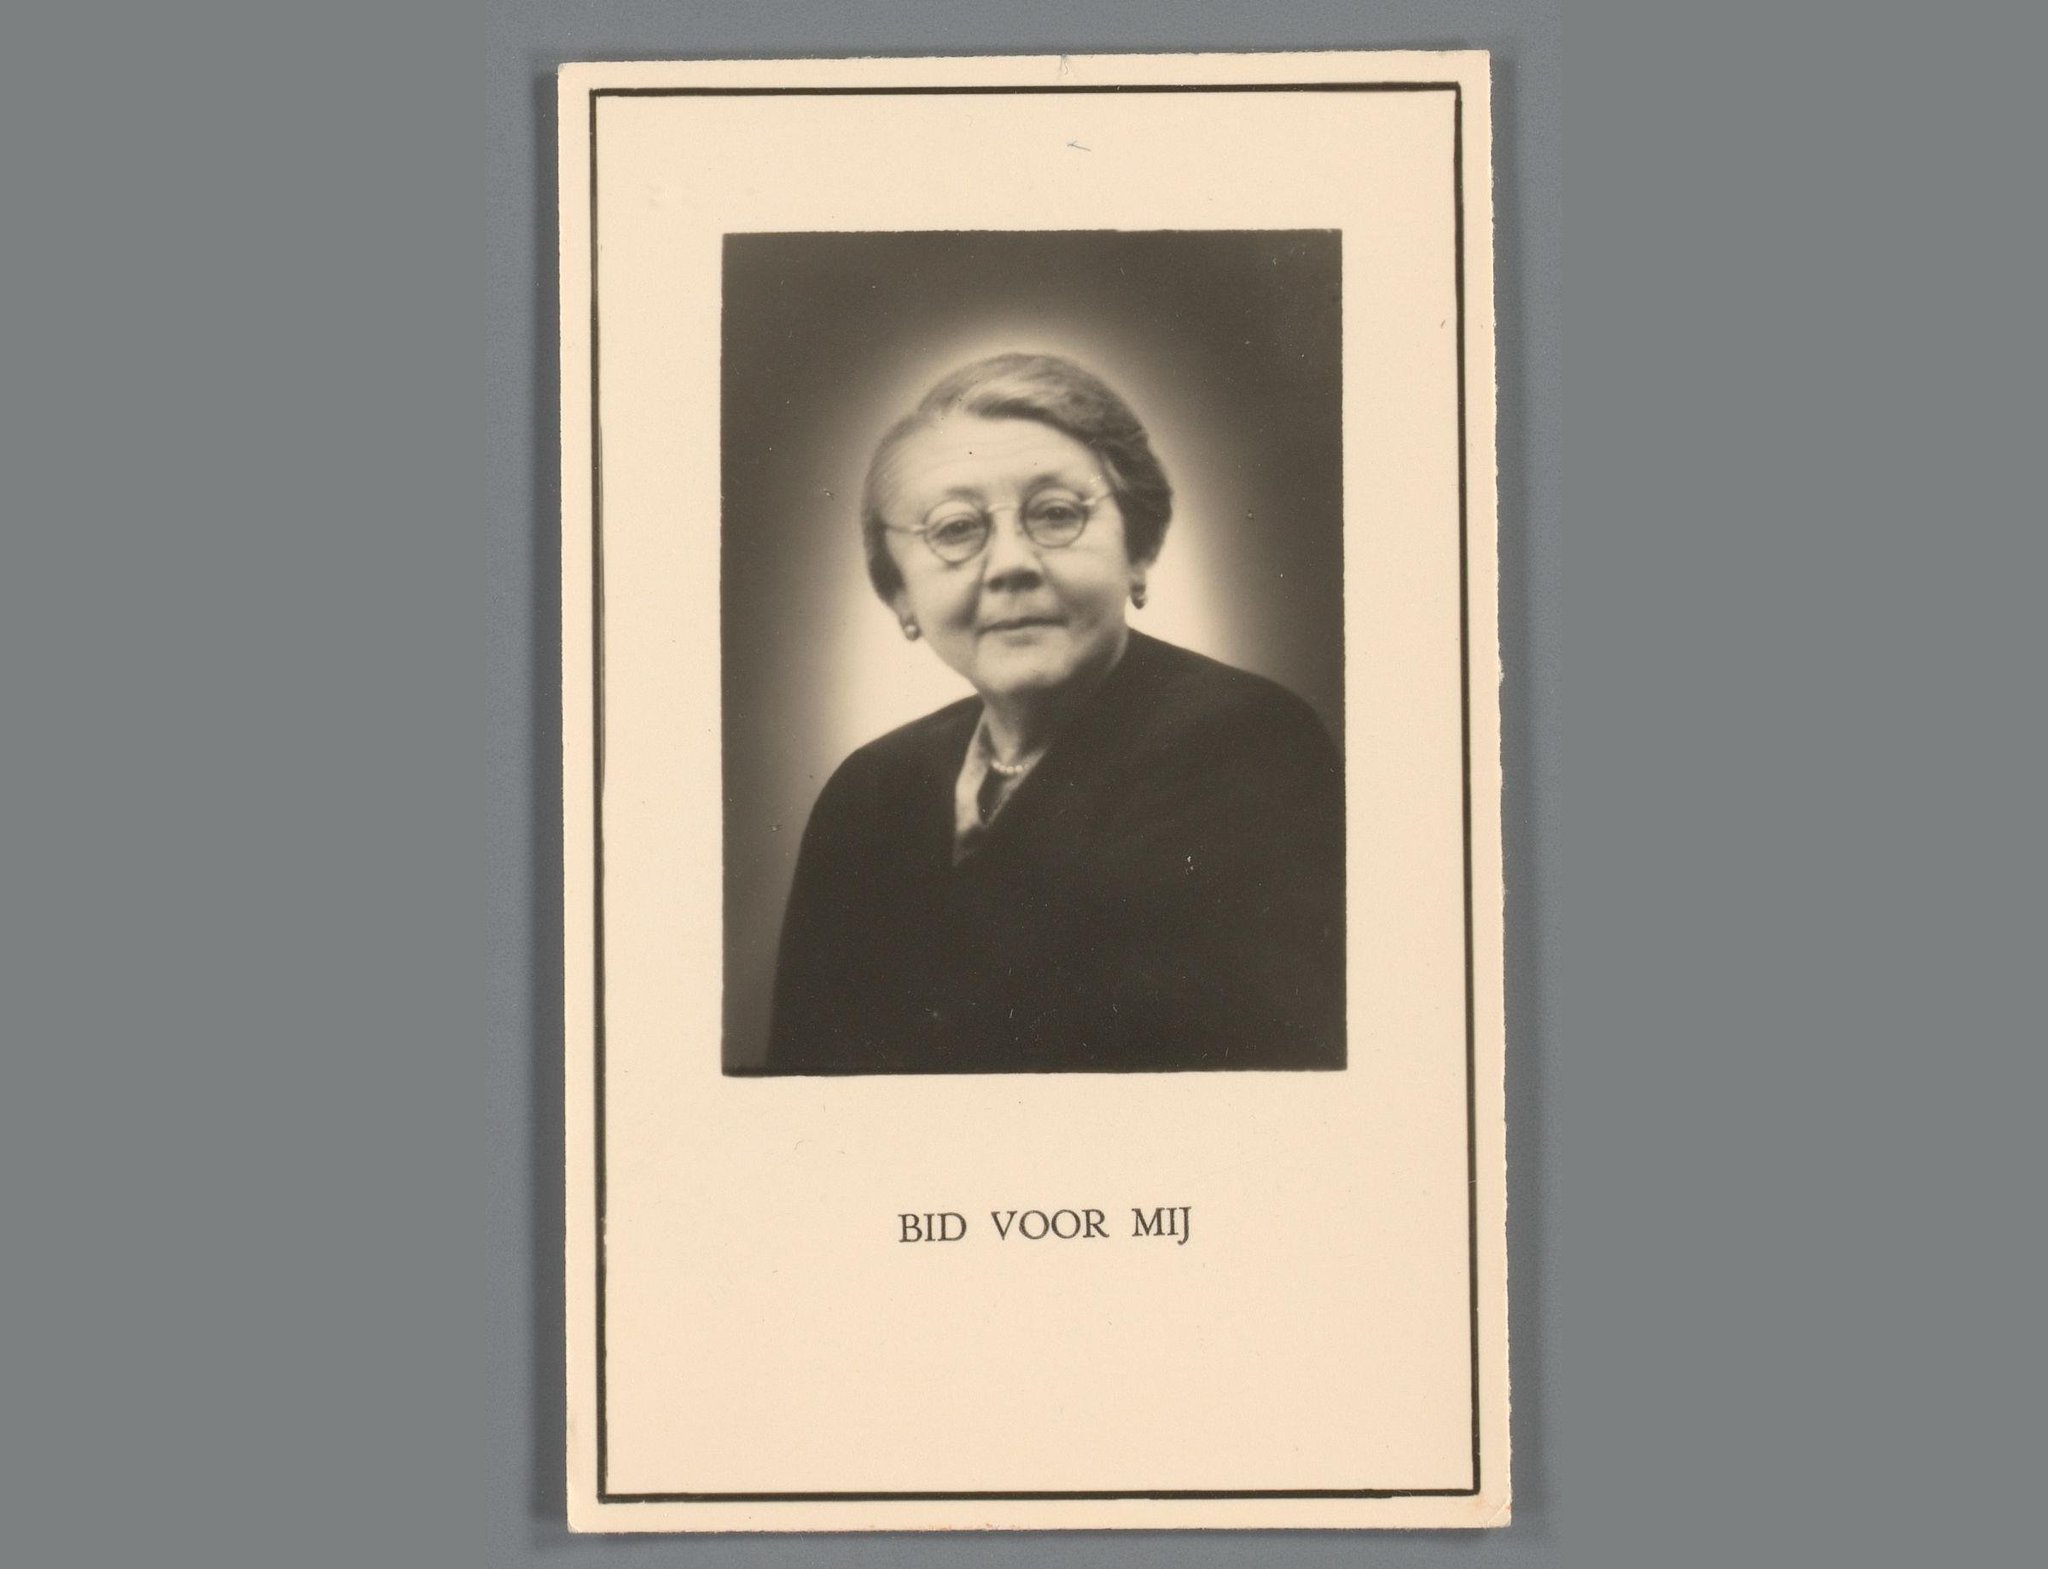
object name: photograph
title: Portret van Agatha Maria Duijn op bidprent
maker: Anonymous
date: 1958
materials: paper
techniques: gelatin silver print, letterpress printing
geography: purmerend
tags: beemster, historical persons, old woman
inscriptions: inscription: ‘In Uw godvruchtig gebed bevelen wij aan (...) Heer, geef haar de eeuwige rust.’, inscription: ‘Leonar’